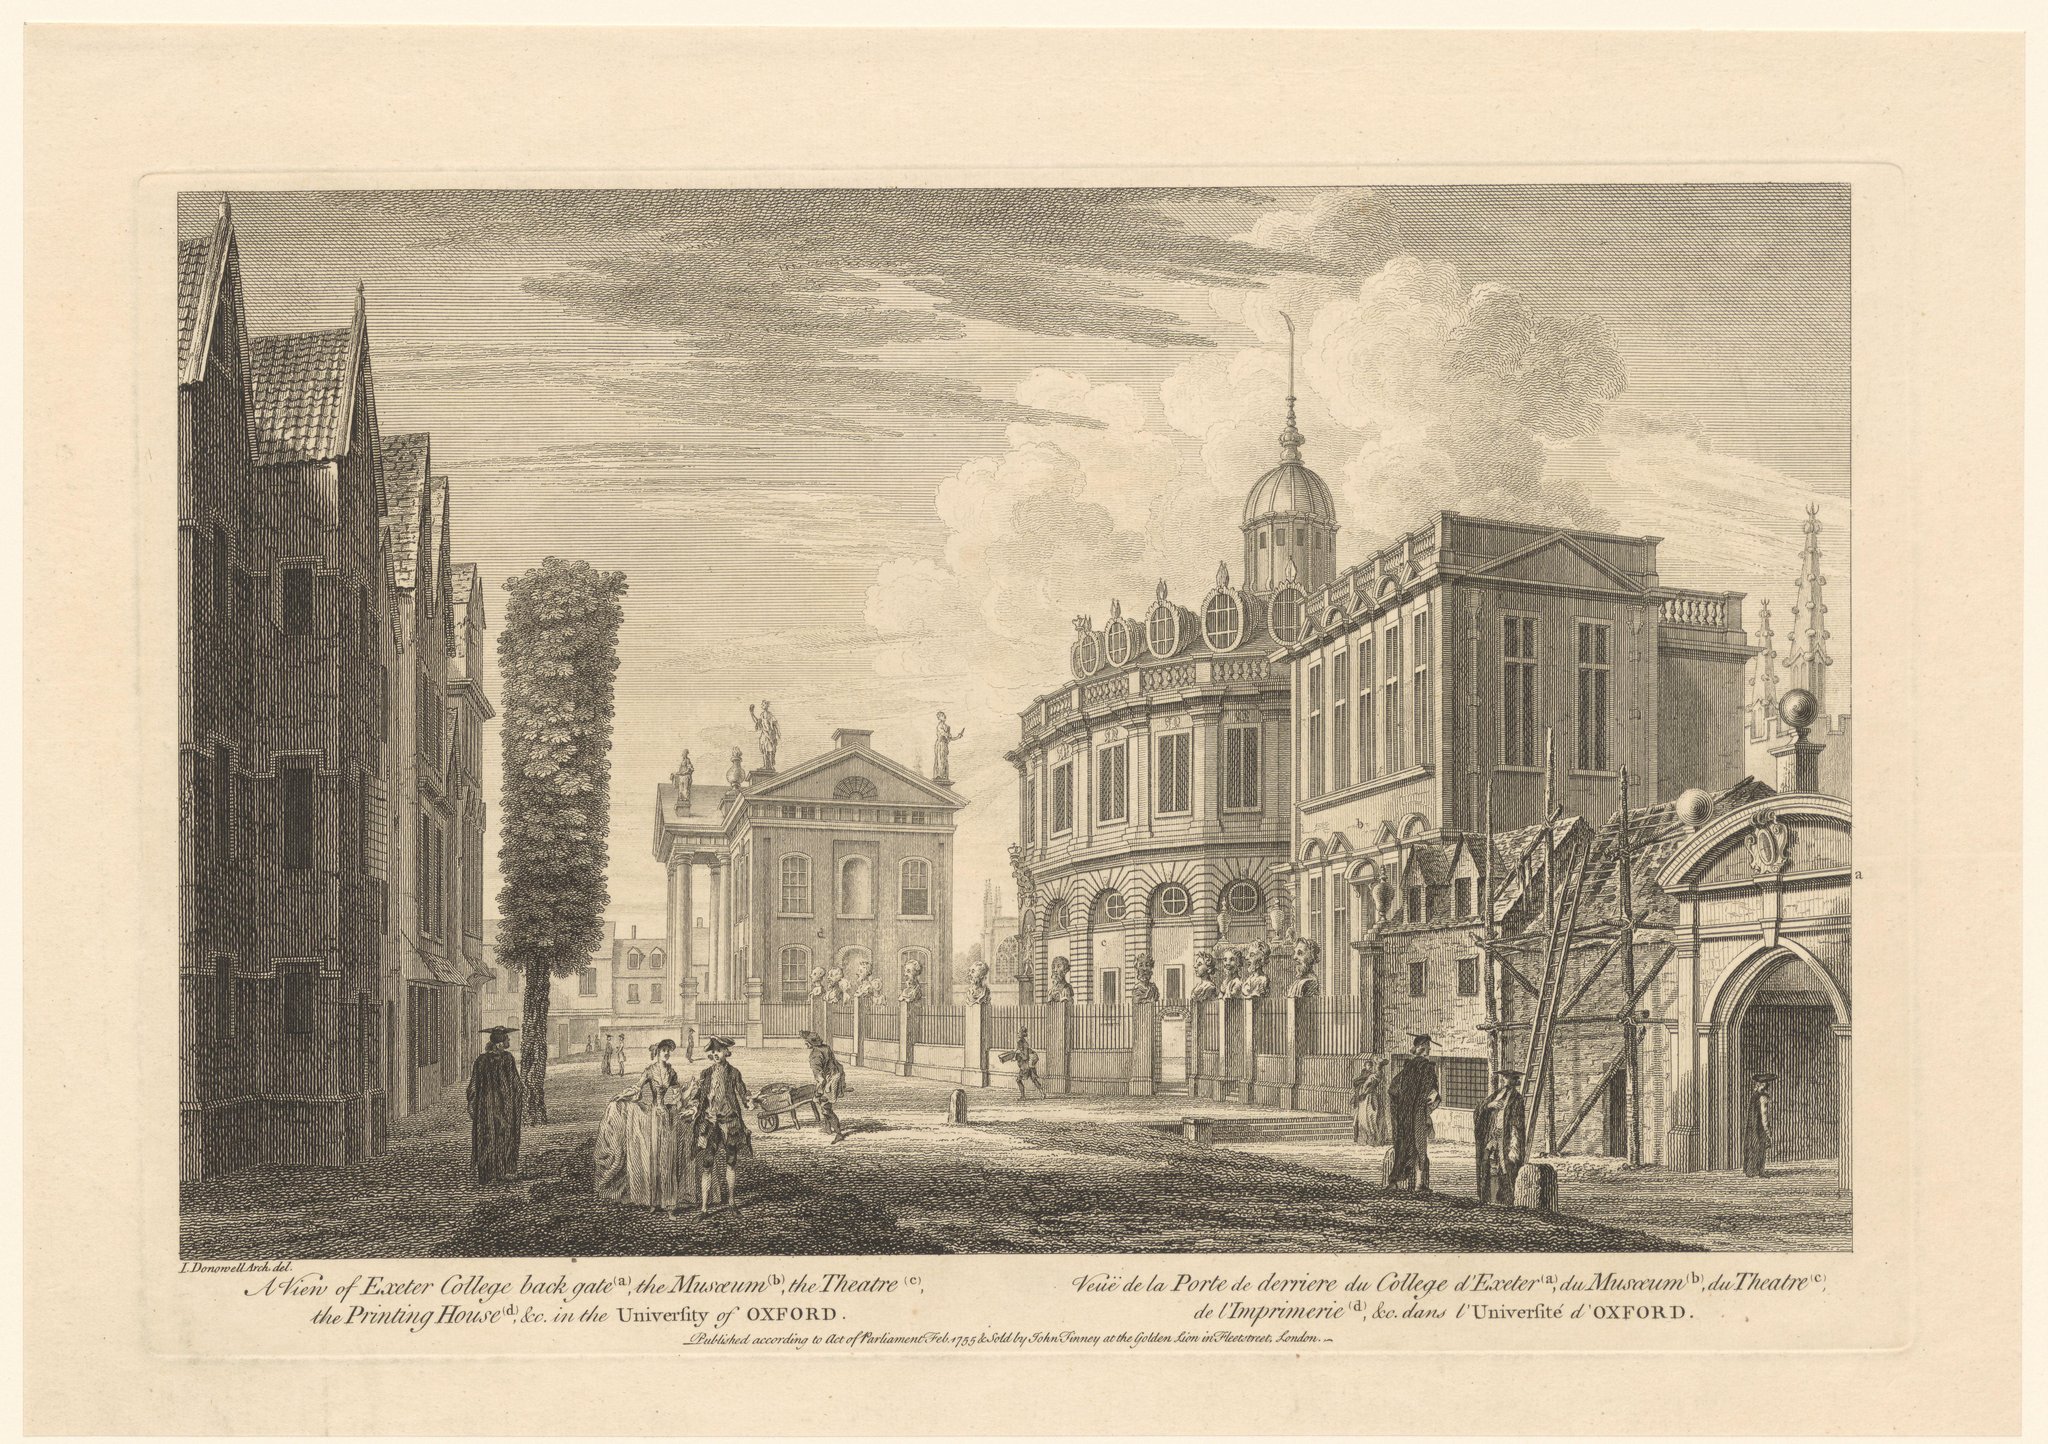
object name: print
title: Gezicht op gebouwen aan Broad Street te Oxford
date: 1702-1755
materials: paper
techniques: etching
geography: london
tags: city-view in general; 'veduta', university building, college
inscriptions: collector's mark: Lugt 2228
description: Gezicht op het Clarendon Building (voormalig uitgever van de universiteit), het Sheldonian Theatre, het Museum of the History of Science en een ingang van Exeter College. Enkele studenten lopen in sub fusc op straat.